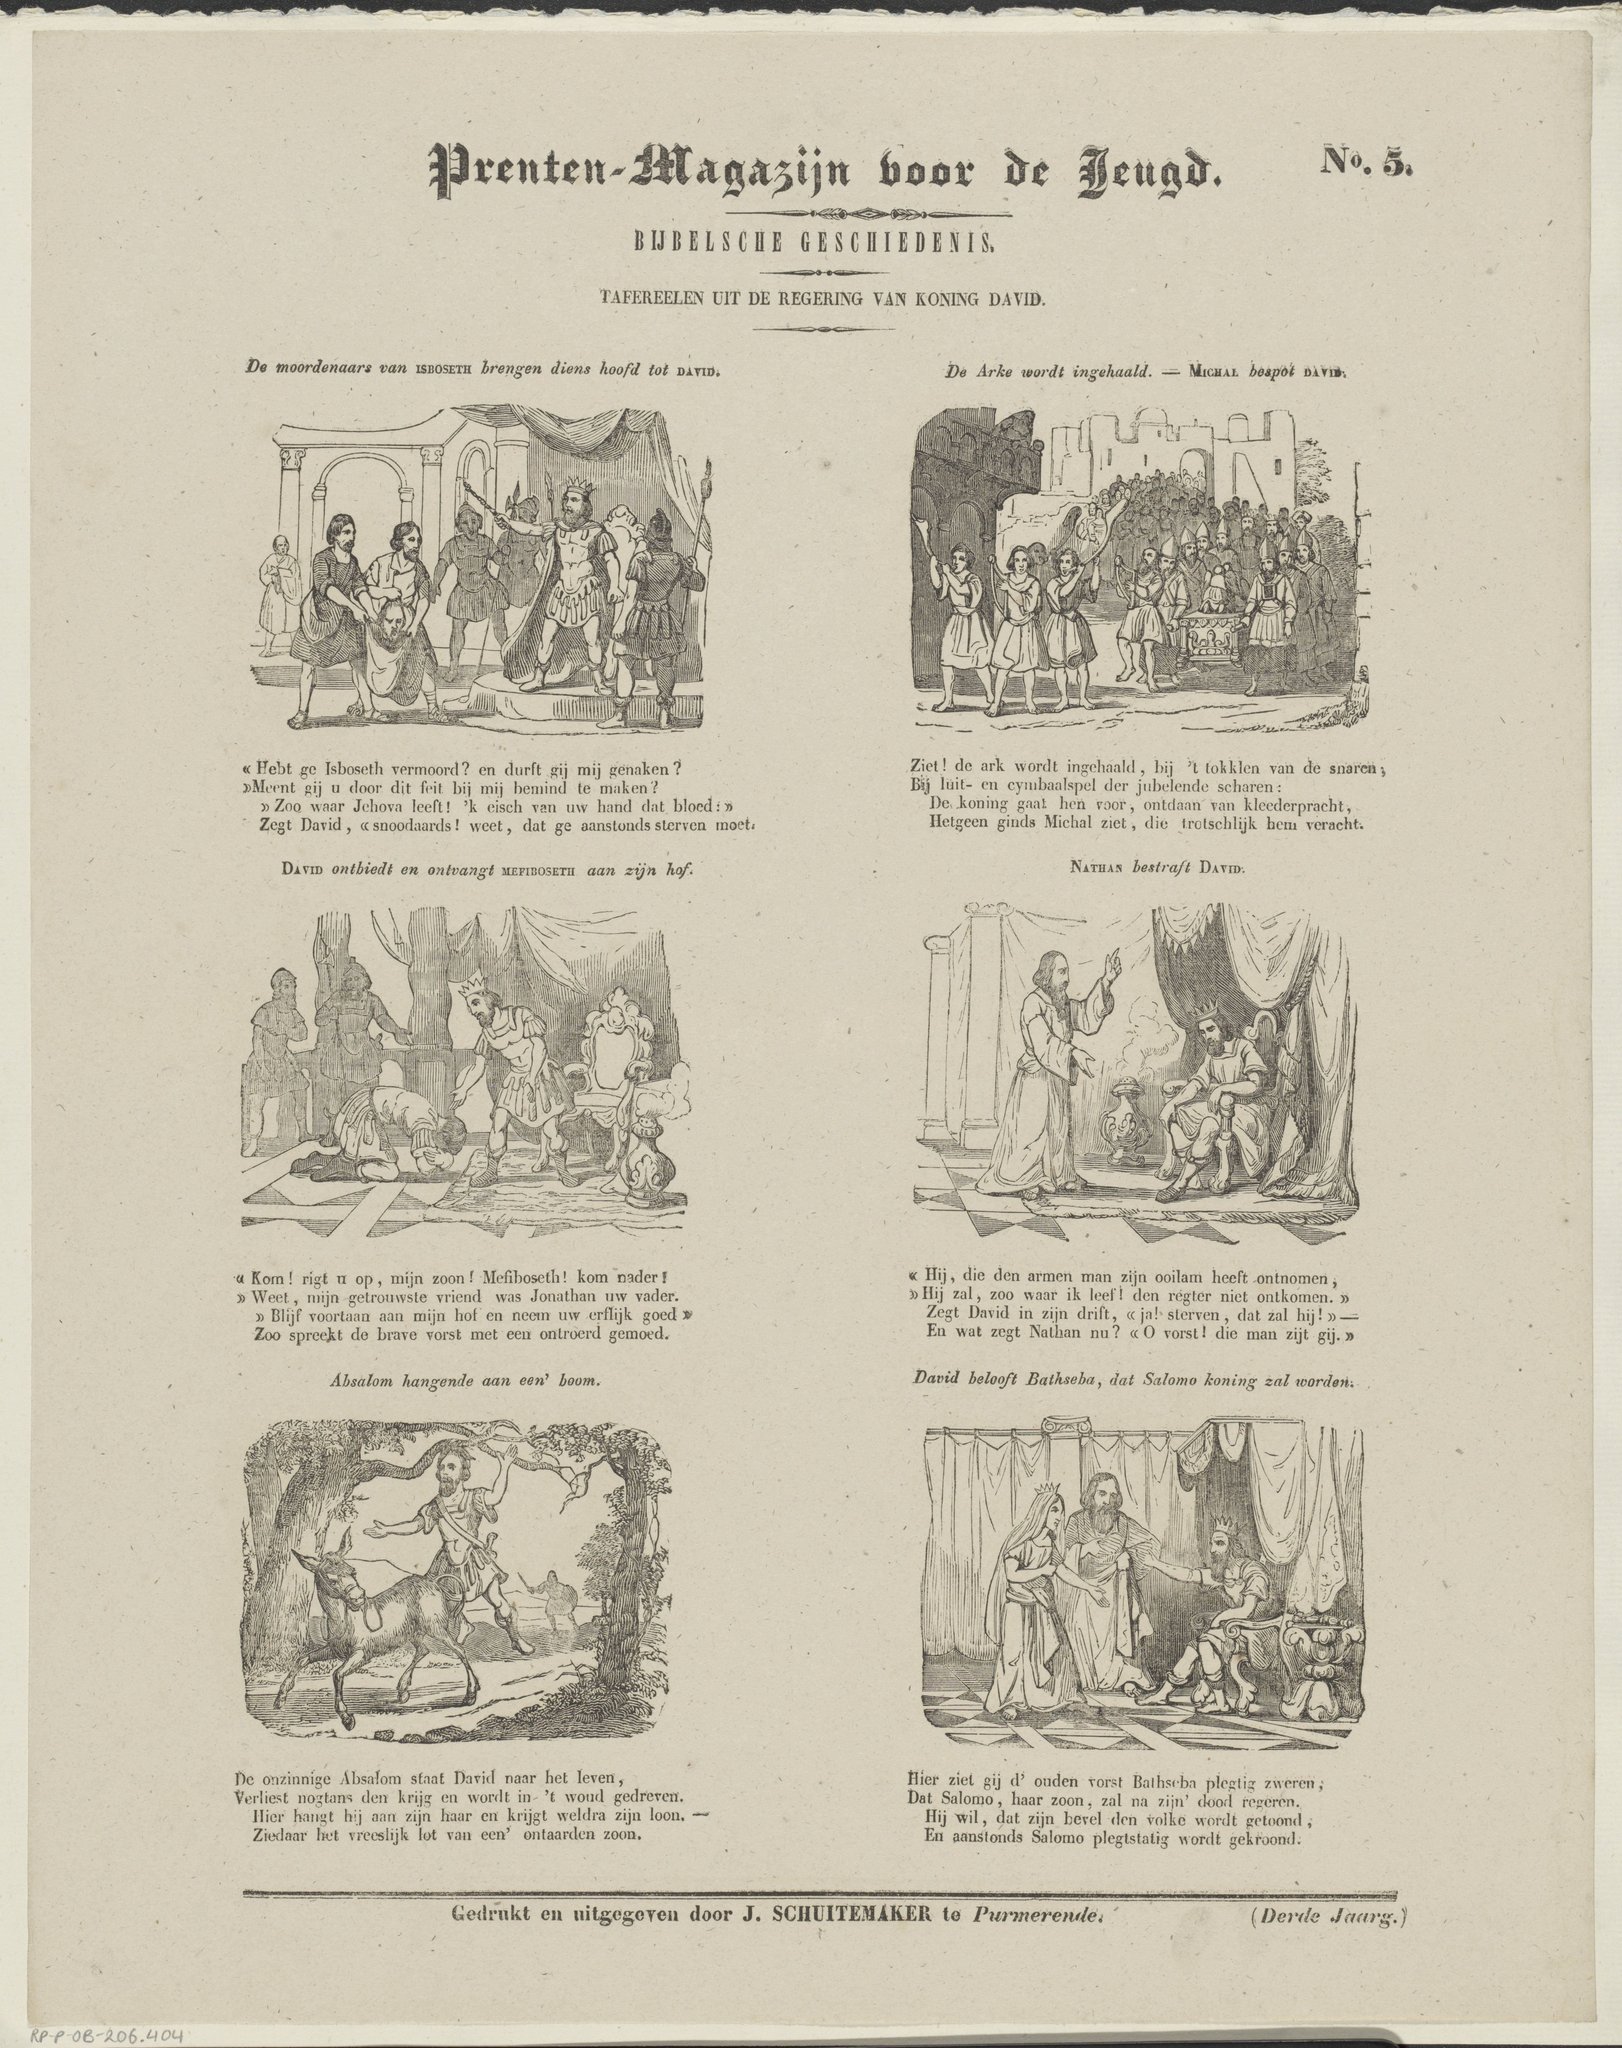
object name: print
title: Prenten-magazijn voor de jeugd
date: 1844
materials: paper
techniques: letterpress printing, engraving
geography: netherlands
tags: story of david, old testament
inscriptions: collector's mark: Lugt 2760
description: Blad met 6 voorstellingen uit het leven van de oudtestamentische koning David. Boven elke voorstelling een titel en onder elke voorstelling een vierregelig vers. Genummerd rechtsboven: No. 5.